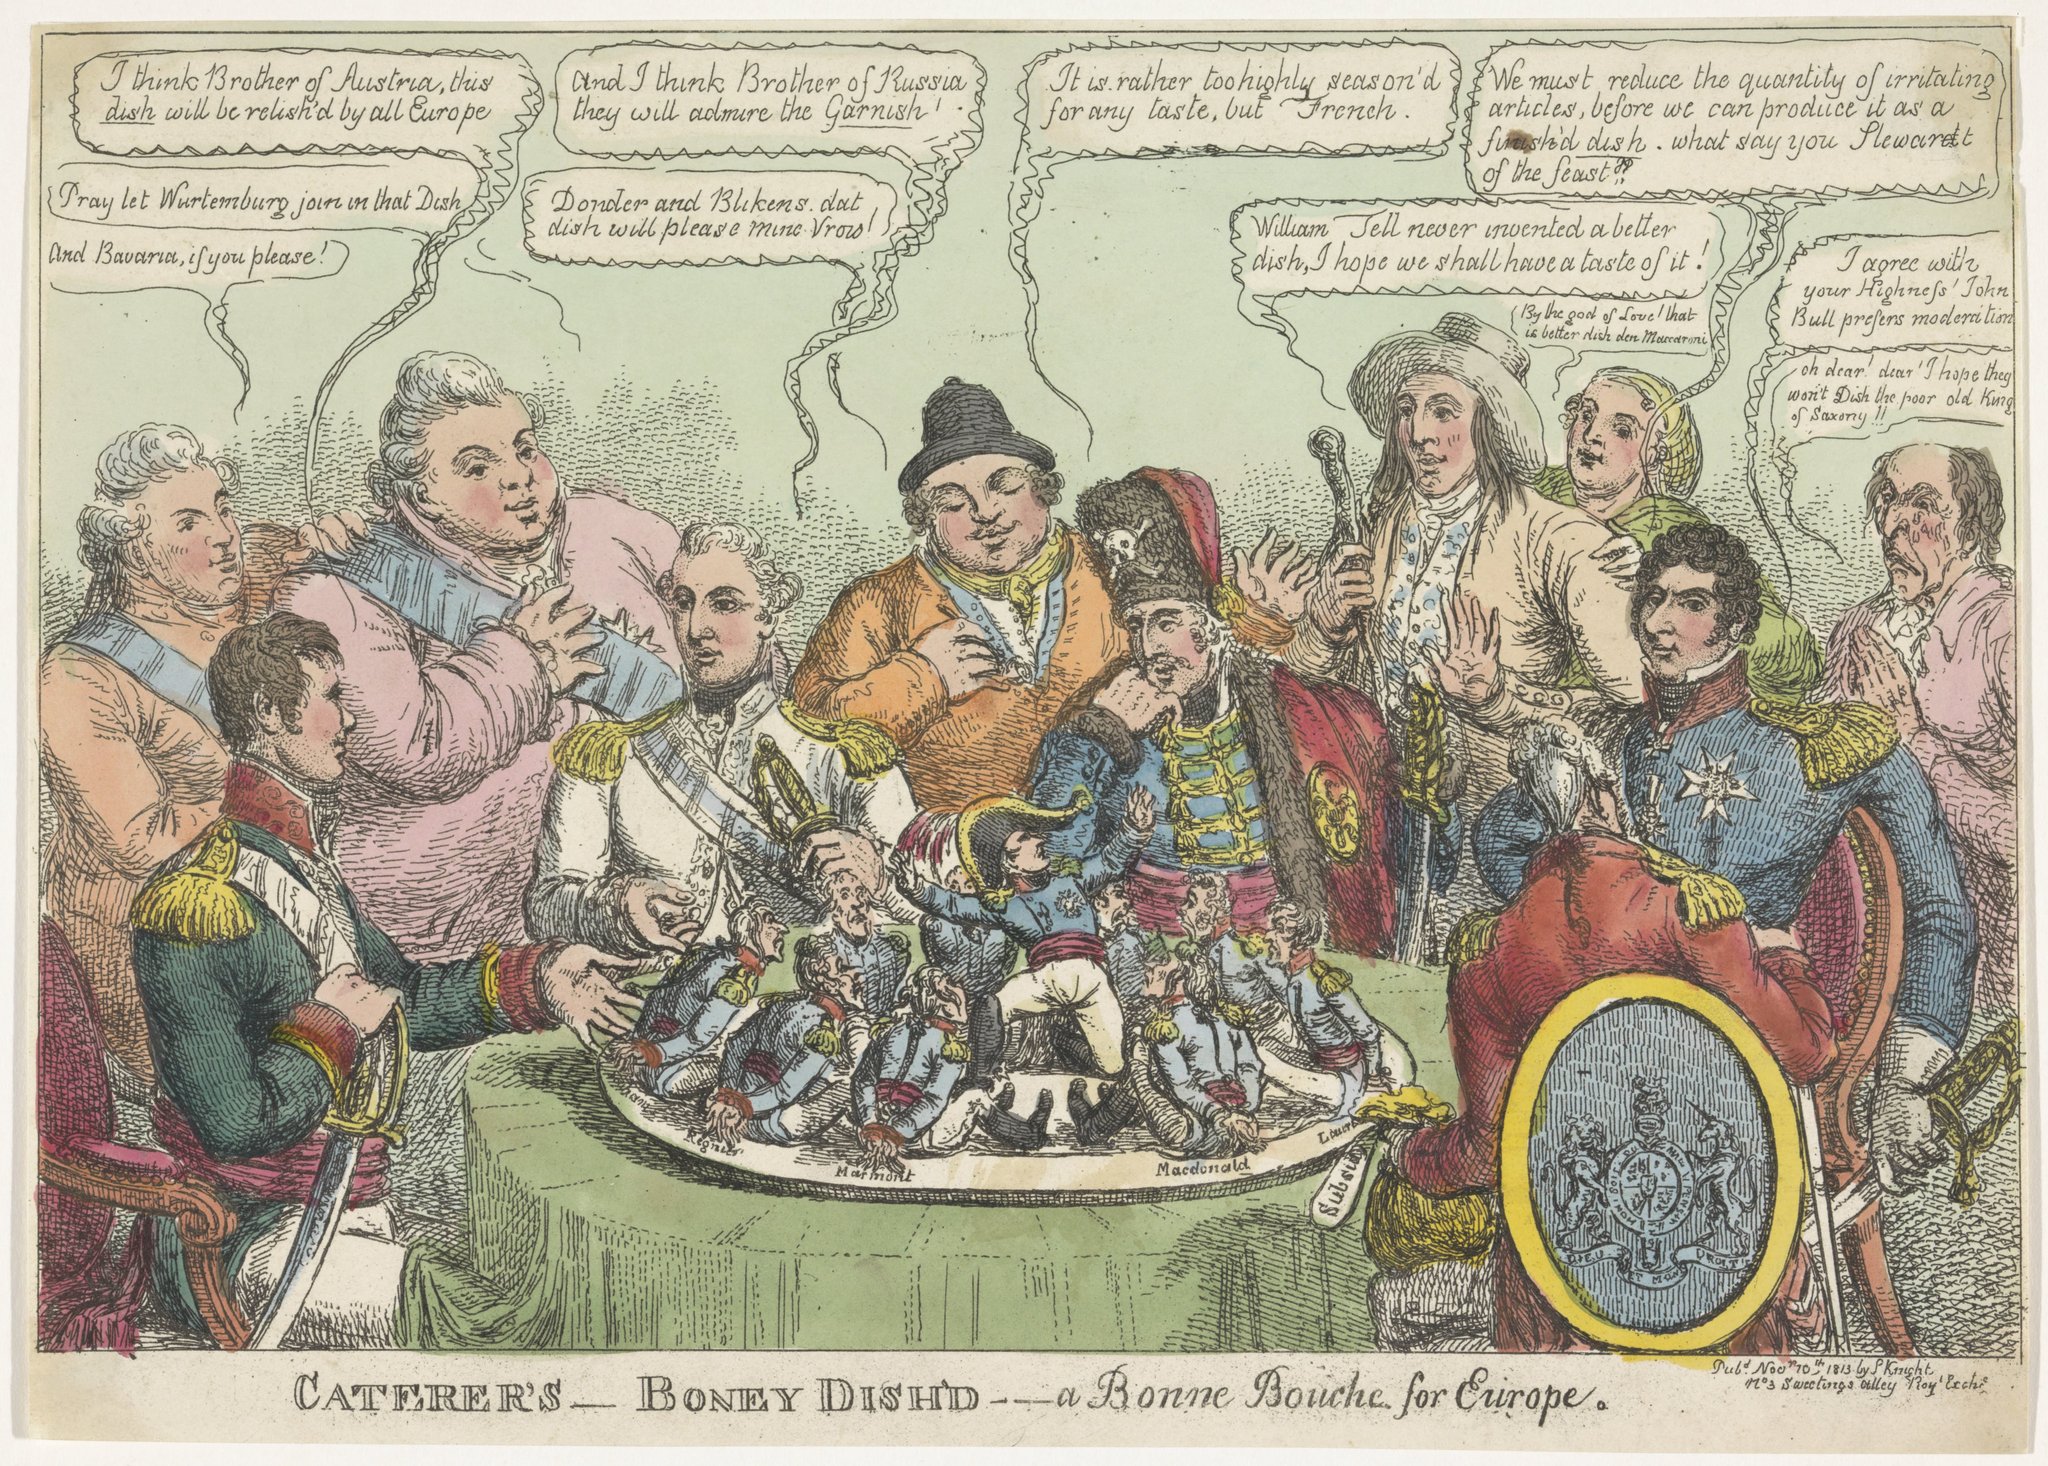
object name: cartoon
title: Caterers' - Boney dish'd - a Bonne Bouche for Europe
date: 1813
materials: paper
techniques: etching, hand coloring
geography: london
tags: london, charles vane (3rd marquess of londonderry), napoleon i (emperor of the french), alexander i (tsaar van rusland), (family) meal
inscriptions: collector's mark: Lugt 2228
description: Spotprent op Napoleon na zijn verlies in de slag bij Leipzig, 1813. Op een ronde tafel staat een schotel bestaande uit Napoleon omringd door zijn maarschalken en generaals. Om de tafel zitten of staan vorsten of vertegenwoordigers van de bondgenoten die de Fransen bij Leipzig hebben verslagen. Links vooraan de Russische tsaar Alexander I, rechts vooraan de Engelse generaal Charles William Vane die in gesprek is met de Zweedse koning Bernadotte. Verder vertegenwoordigers van Beieren, Oostenrijk, Württemberg, Nederland, Pruisen, Zwitserland, Italië en Saksen. De Hollander zegt 'Donder and Blikens, dat dish will please mine Vrow!"